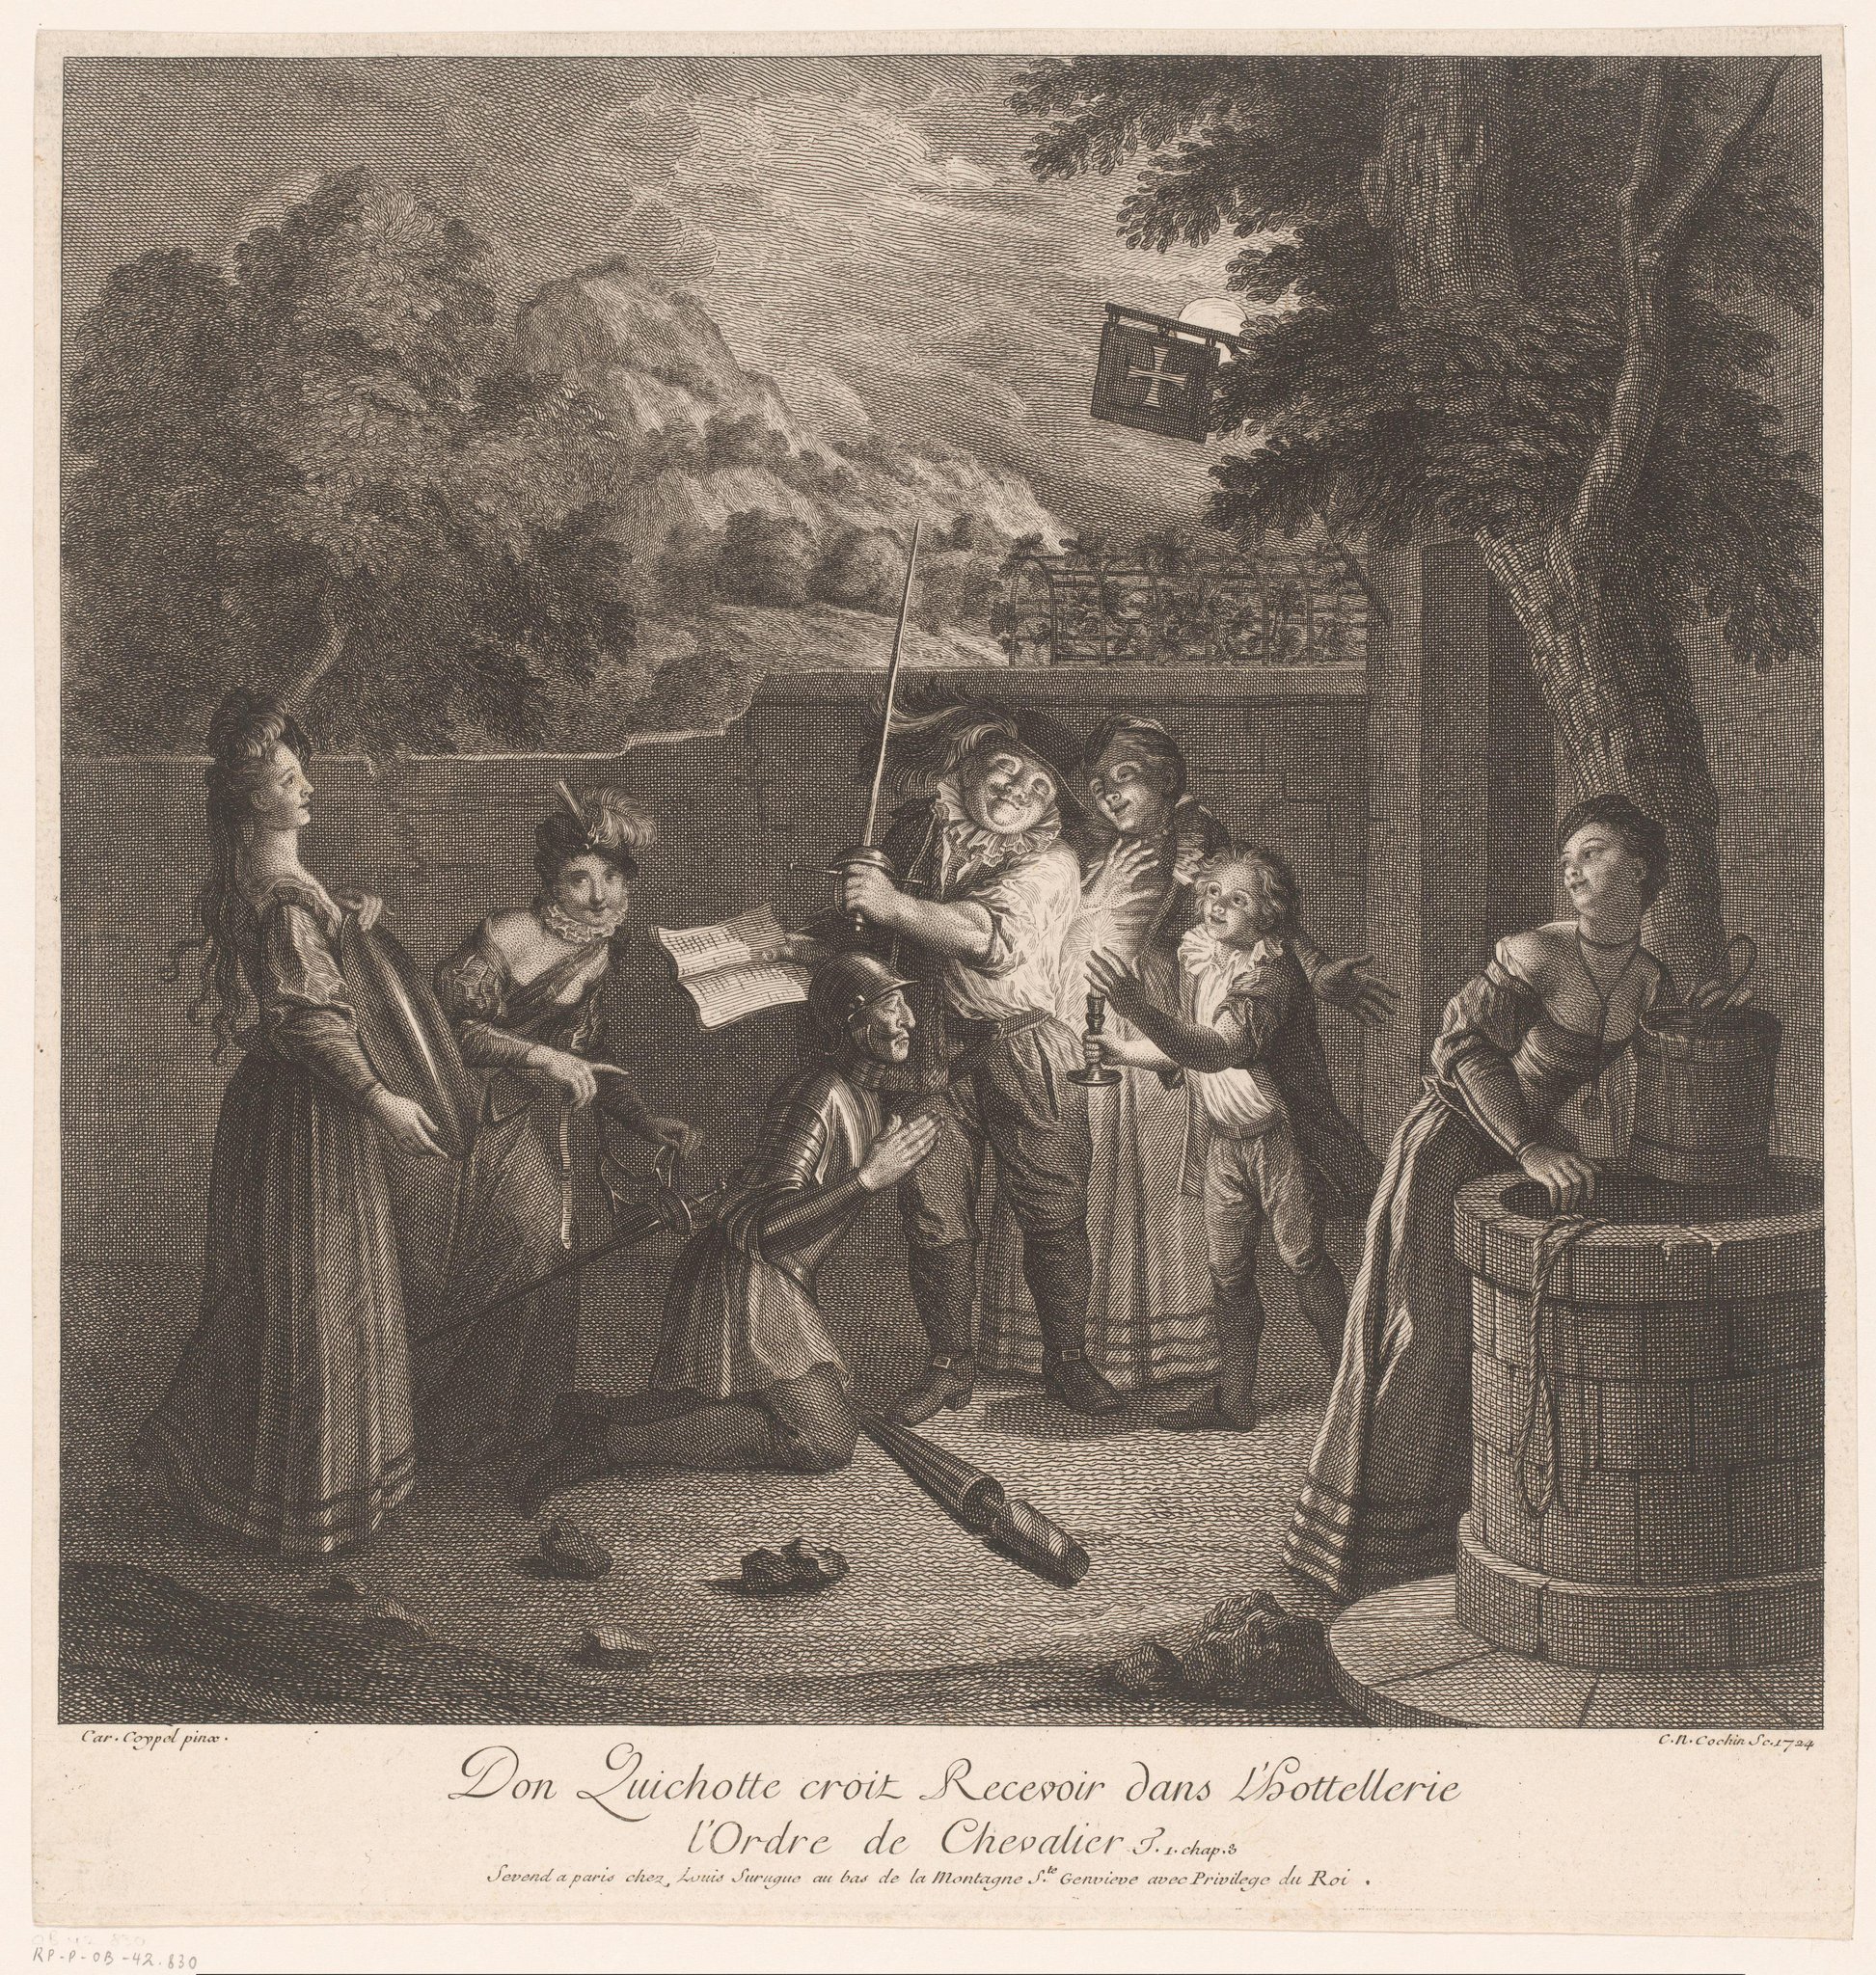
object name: print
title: Don Quichot ontvangt de ridderorde in de herberg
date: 1724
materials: paper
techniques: engraving, etching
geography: paris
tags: don quixote, becoming a knight, knighting, hotel, hostelry, inn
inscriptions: collector's mark: Lugt 240